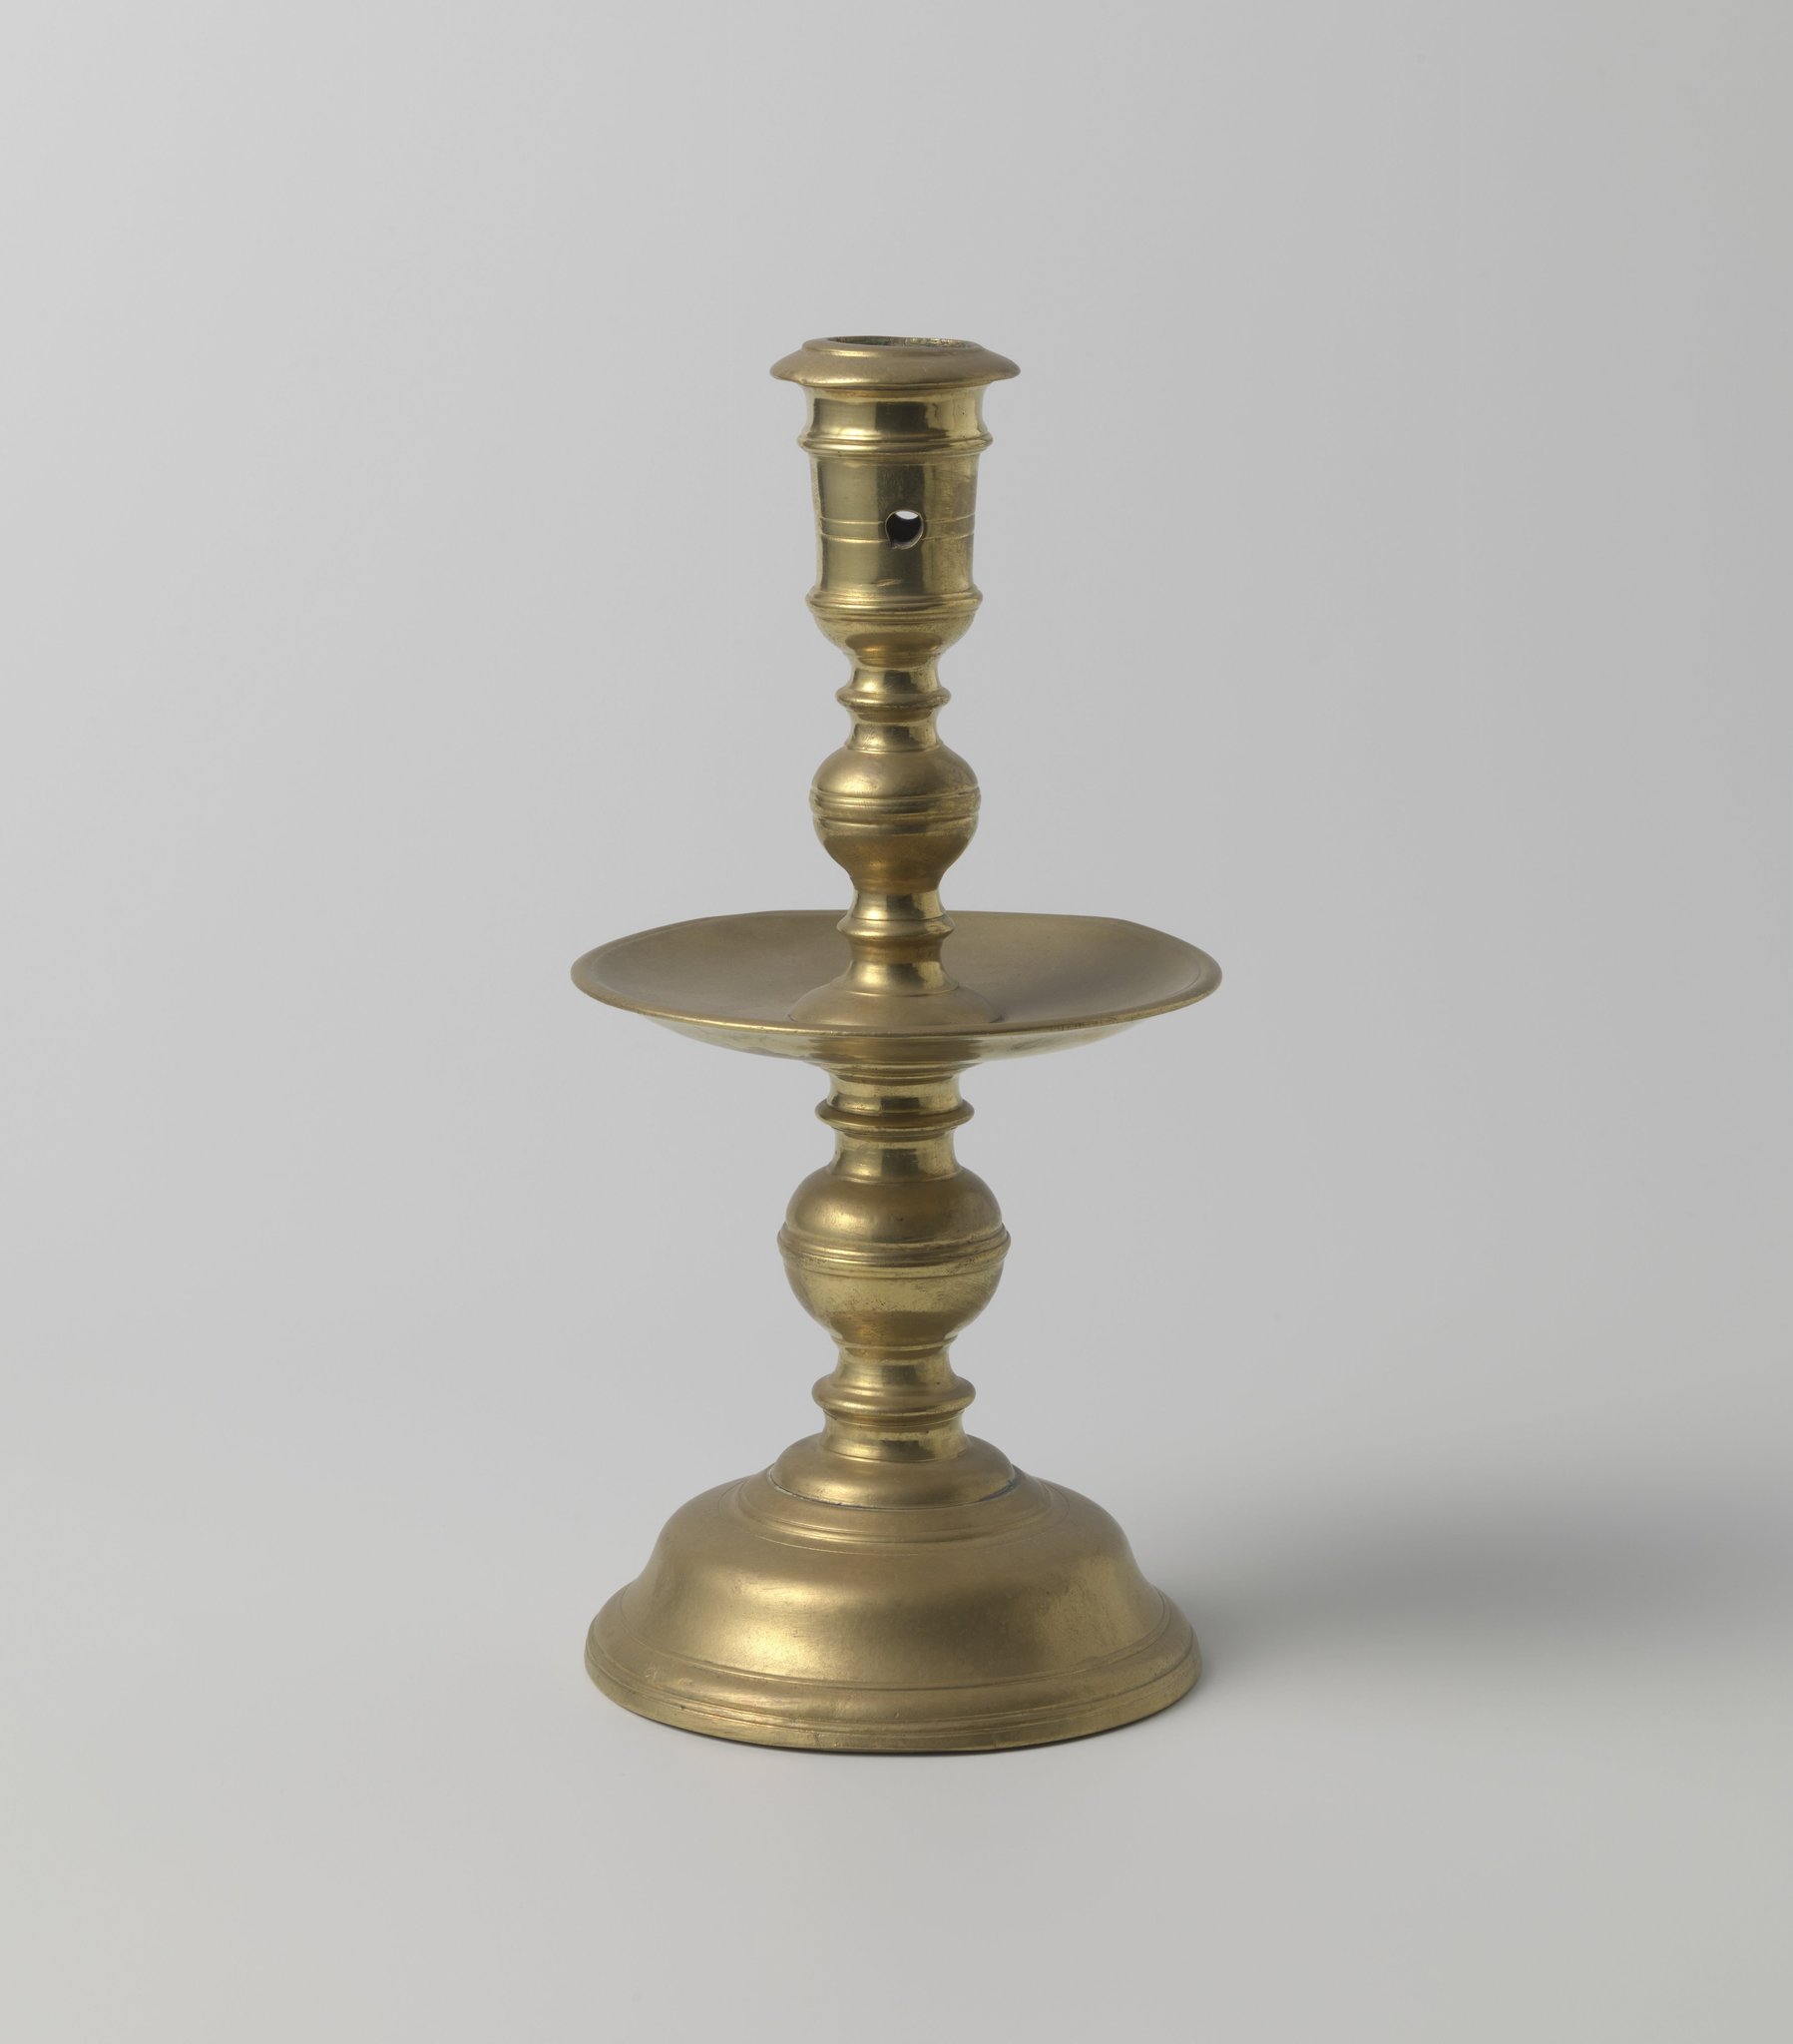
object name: candlestick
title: Kraagkandelaar van messing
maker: Anonymous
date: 1650-1700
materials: brass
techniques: casting, riveted, turning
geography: northern netherlands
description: De kandelaar is in vier delen gegoten en afgedraaid: de voet, het onderste gedeelte van de stam, de kraag, het bovenste deel van de stam met de kaarsenhouder. Op de ronde geprofileerde voet volgt het onderste stamgedeelte met een rib boven en onder een bolvormige met een geprofileerde rib versierde baluster. De kraag is aan de bovenkant met een ring versierd. Het bovenste deel van de stam herhaalt de vorm van de onderste. De geprofileerde cylindrische houder heeft in het midden van de wand twee ronde gaten. Het bovenste gedeelte van de stam is voorzien van een pin, die door het onderste gedeelte is gestoken en onder in de voet is vastgeklonken. Een kandelaar van dit type wordt kraag- of schijfkandelaar genoemd.